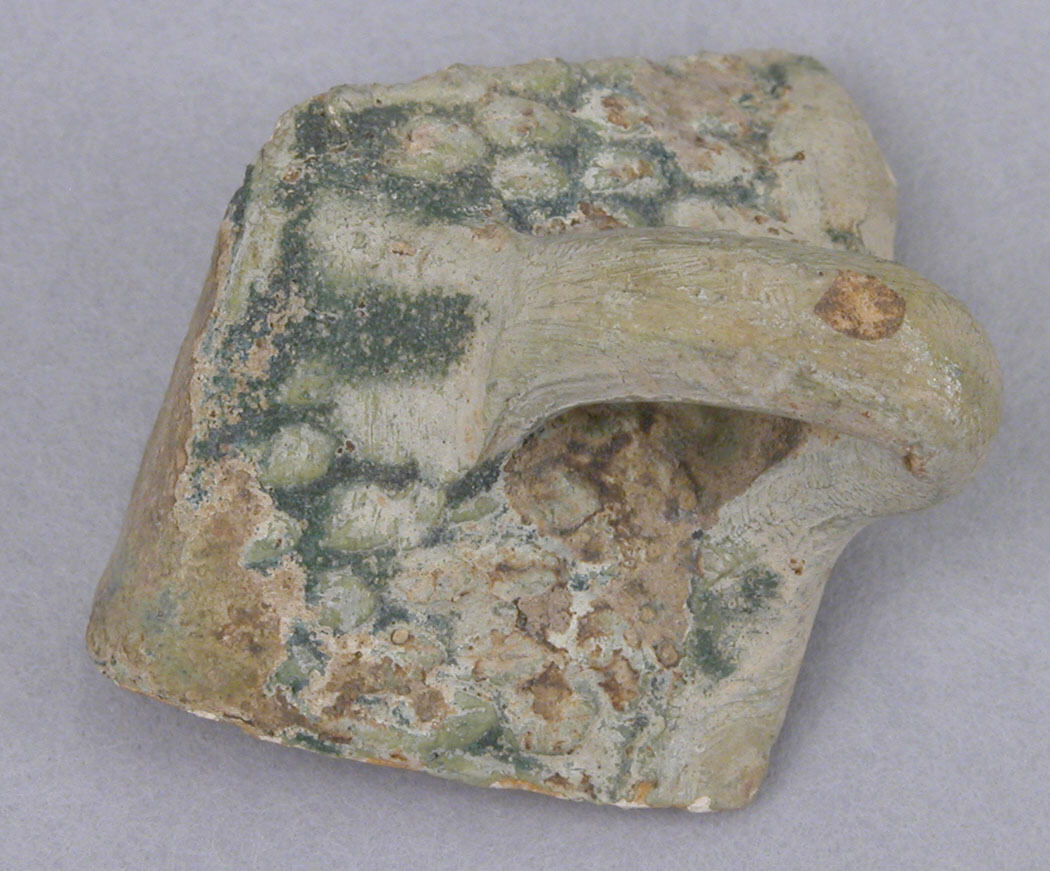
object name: fragment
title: Ceramic Fragment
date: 701-900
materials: earthenware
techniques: glazing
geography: iraq